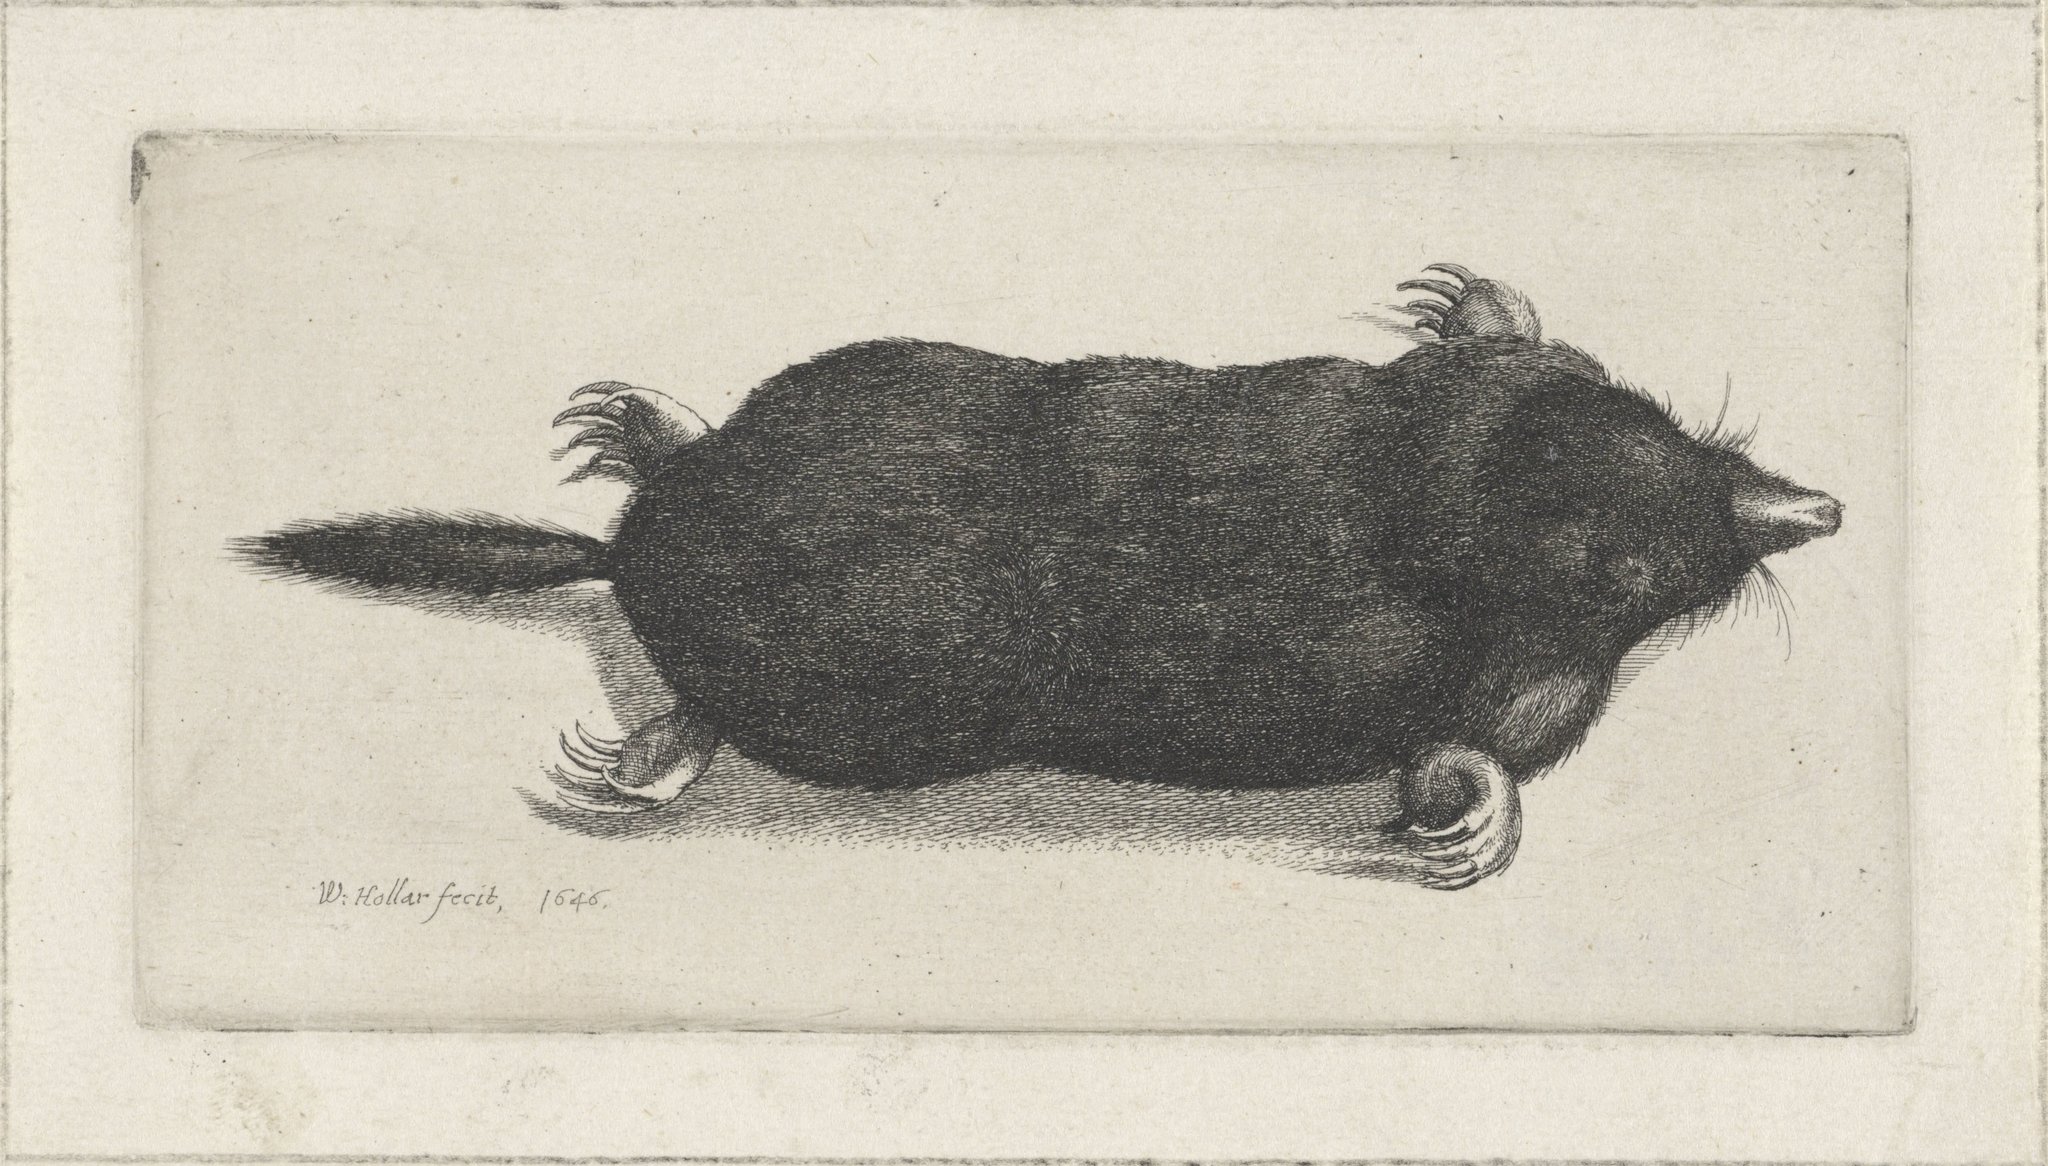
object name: print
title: Dode mol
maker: wenceslaus hollar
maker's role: draughtsman, print maker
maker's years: 1607-1677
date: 1646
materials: paper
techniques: etching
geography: antwerp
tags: other mammals: mole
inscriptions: collector's mark: Lugt 240